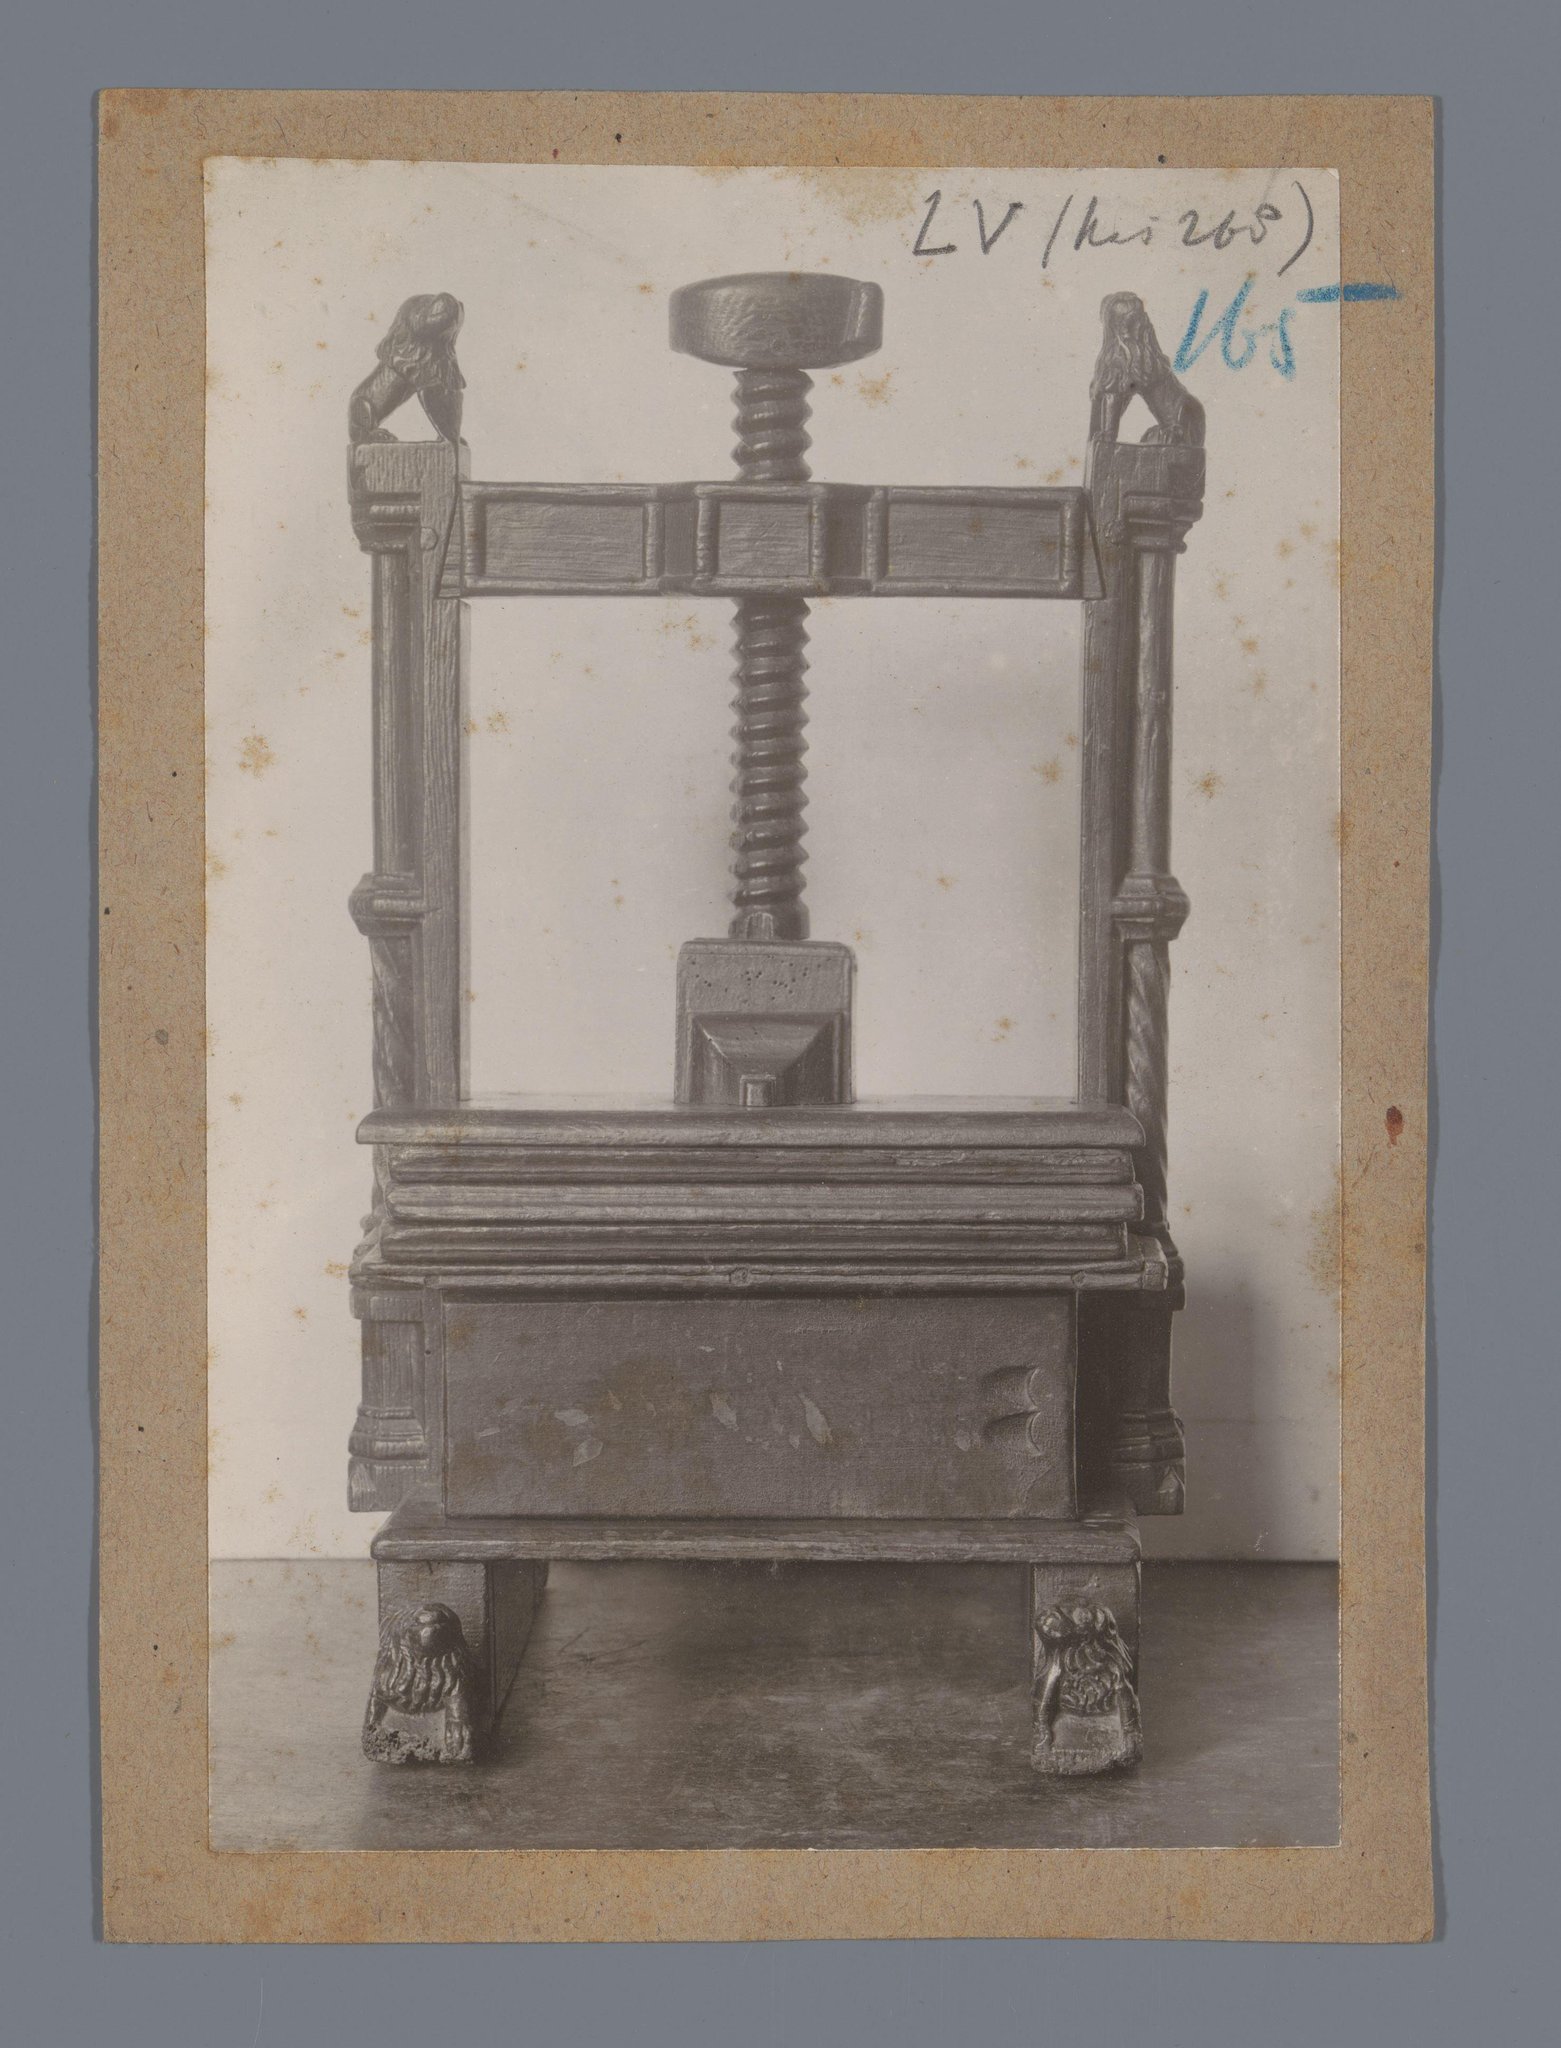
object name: photograph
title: Pers gedecoreerd met leeuwen, vermoedelijk een linnenpers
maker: Anonymous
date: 1875-1900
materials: photographic support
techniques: matte daylight collodion silver print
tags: tools, aids, implements ~ crafts and industries: press, beasts of prey, predatory animals: lion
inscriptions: number: ‘LV (Kat 263) 165’, collector's mark: ‘Instituut voor kunst-nijverheidsonderwijs Gabriël Metsustraat No. 16, Amsterdam’, collector's mark: ‘Kunstnijverheidschool Quellinus Amsterdam Frans Halsstraat 14.’